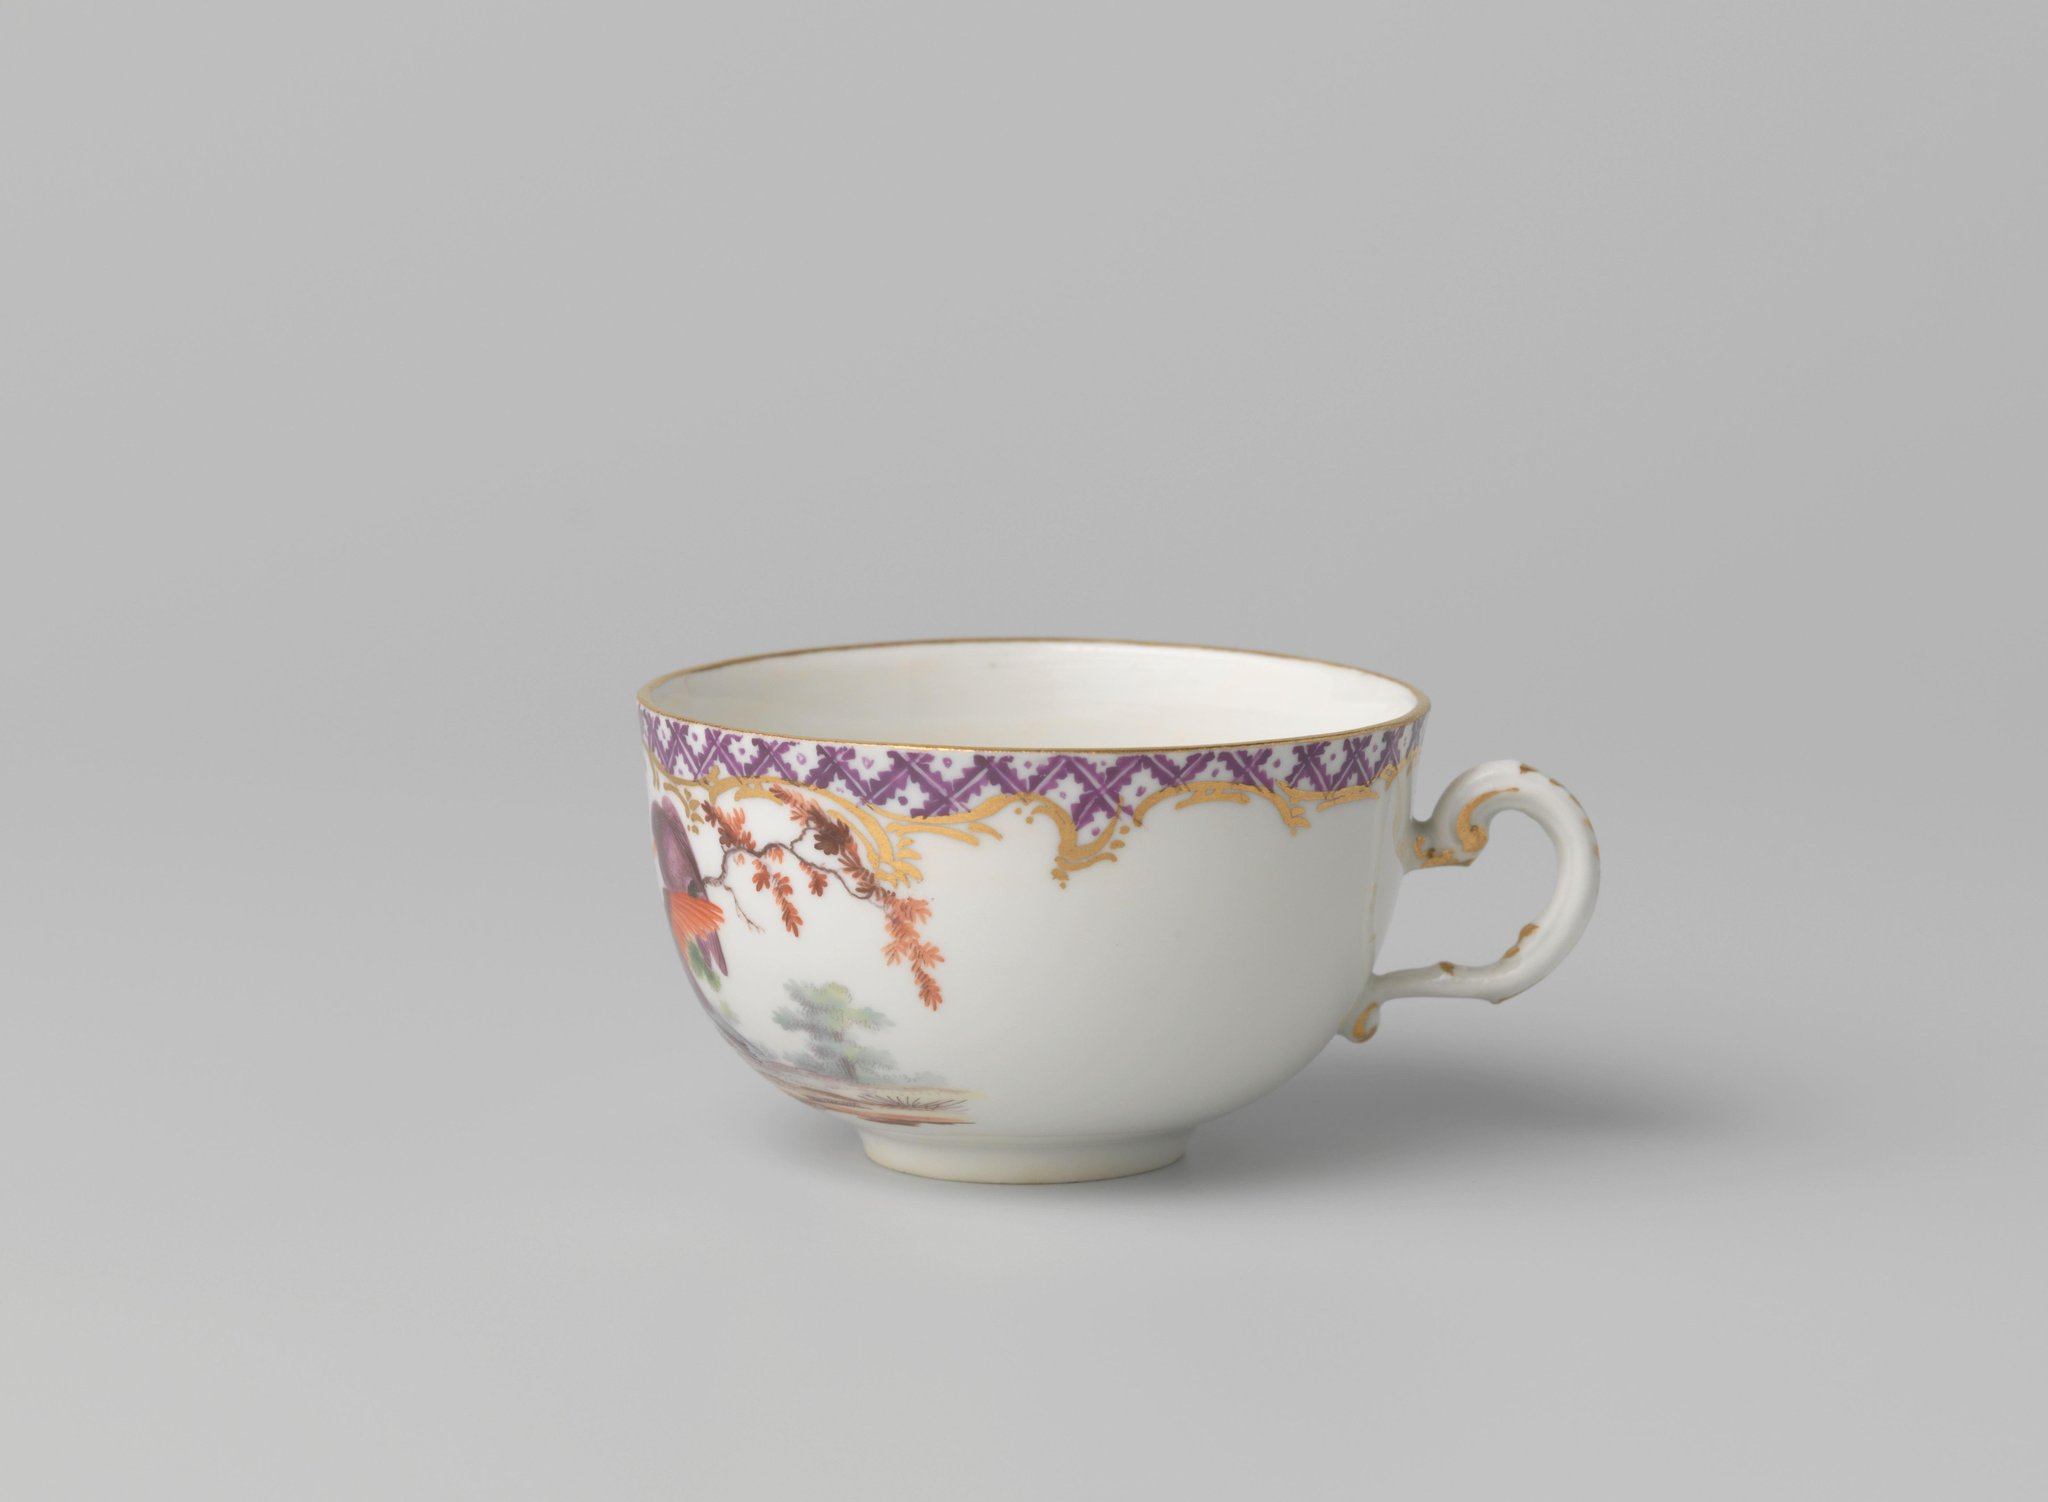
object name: cup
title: Cup with birds in a landscape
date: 1765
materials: glaze, gold, paint, porcelain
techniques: firing, forming, gilding, turning, vitrification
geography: ansbach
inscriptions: mark: ‘A/ I’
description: Kop van porselein en een gekruld oor in de vorm van een bladrank, beschilderd op het glazuur in emailkleuren en goud. Op de buitenwand vogels in een landschap. De buitenrand met een band met servetwerk, waaronder gouden ranken. Strooibloemen op de bodem. Gouden rand. Gemerkt op de onderzijde met de A en I.